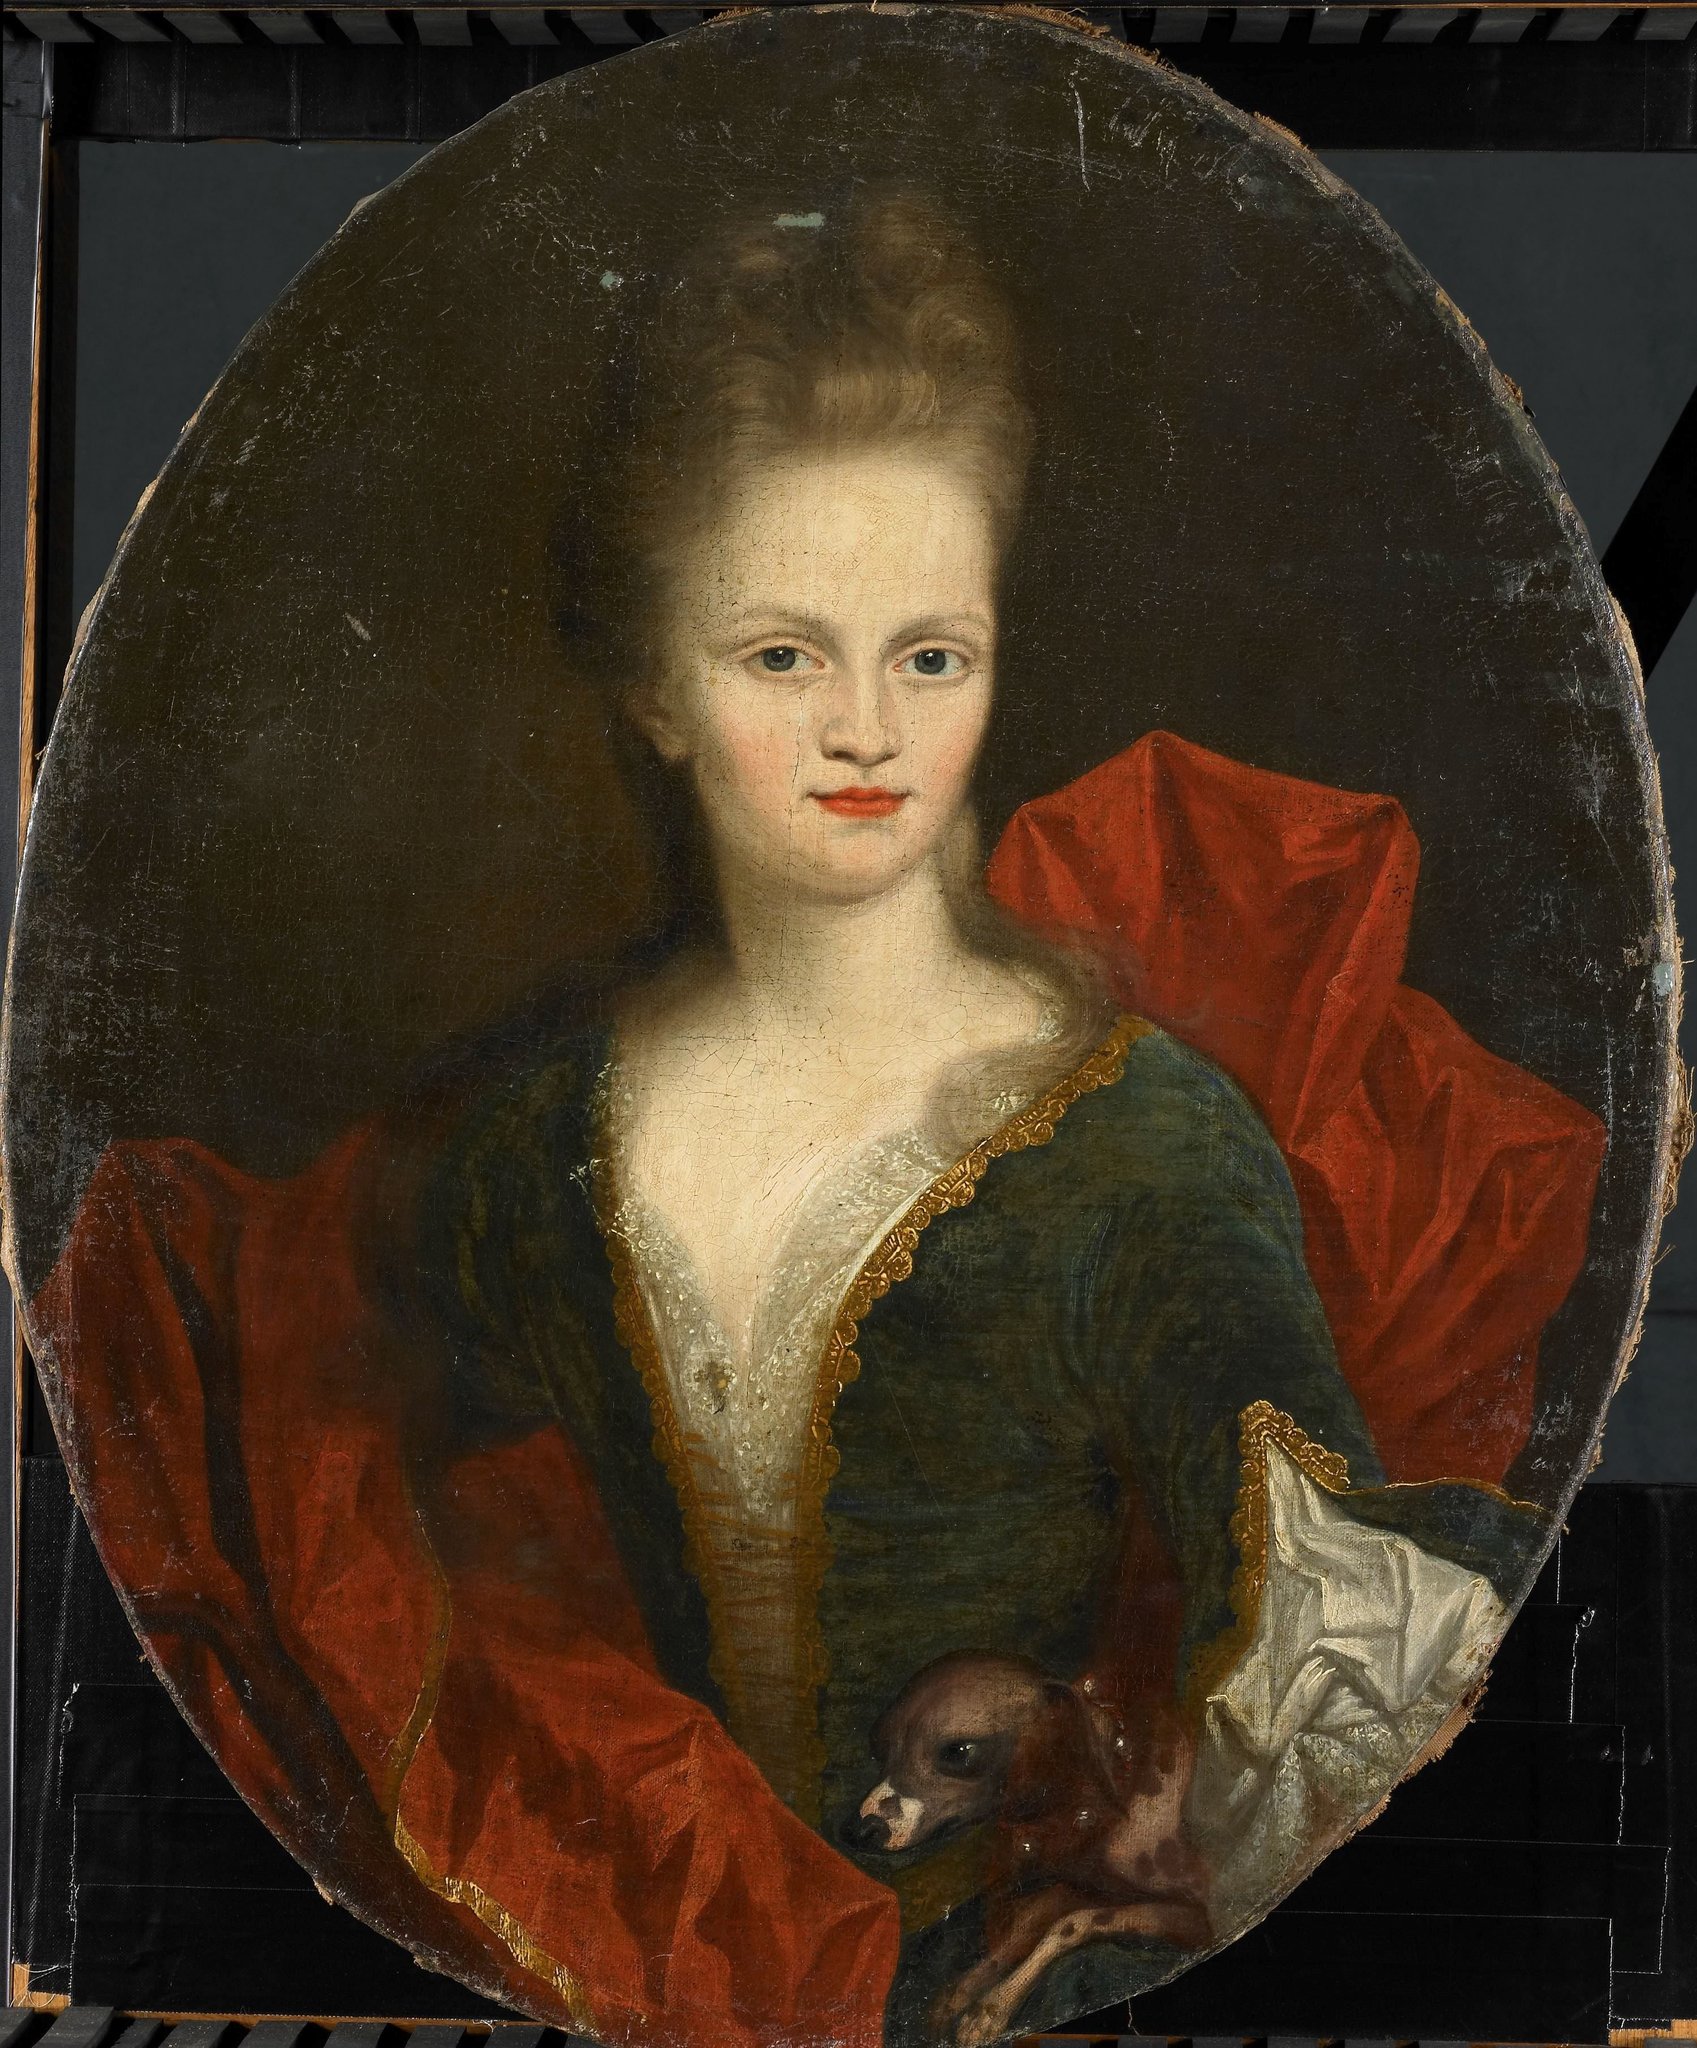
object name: painting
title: Anna Margaretha van Petcum (1676-1745), Wife of Johan Arnold Zoutman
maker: johan van diest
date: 1690-1720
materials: canvas, oil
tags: historical persons - bb - woman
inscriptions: signature: ‘V.Diest F’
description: Ovaal portret van Anna Margaretha van Petcum, echtgenote van Johan Arnold Zoutman, met een hondje op de schoot.